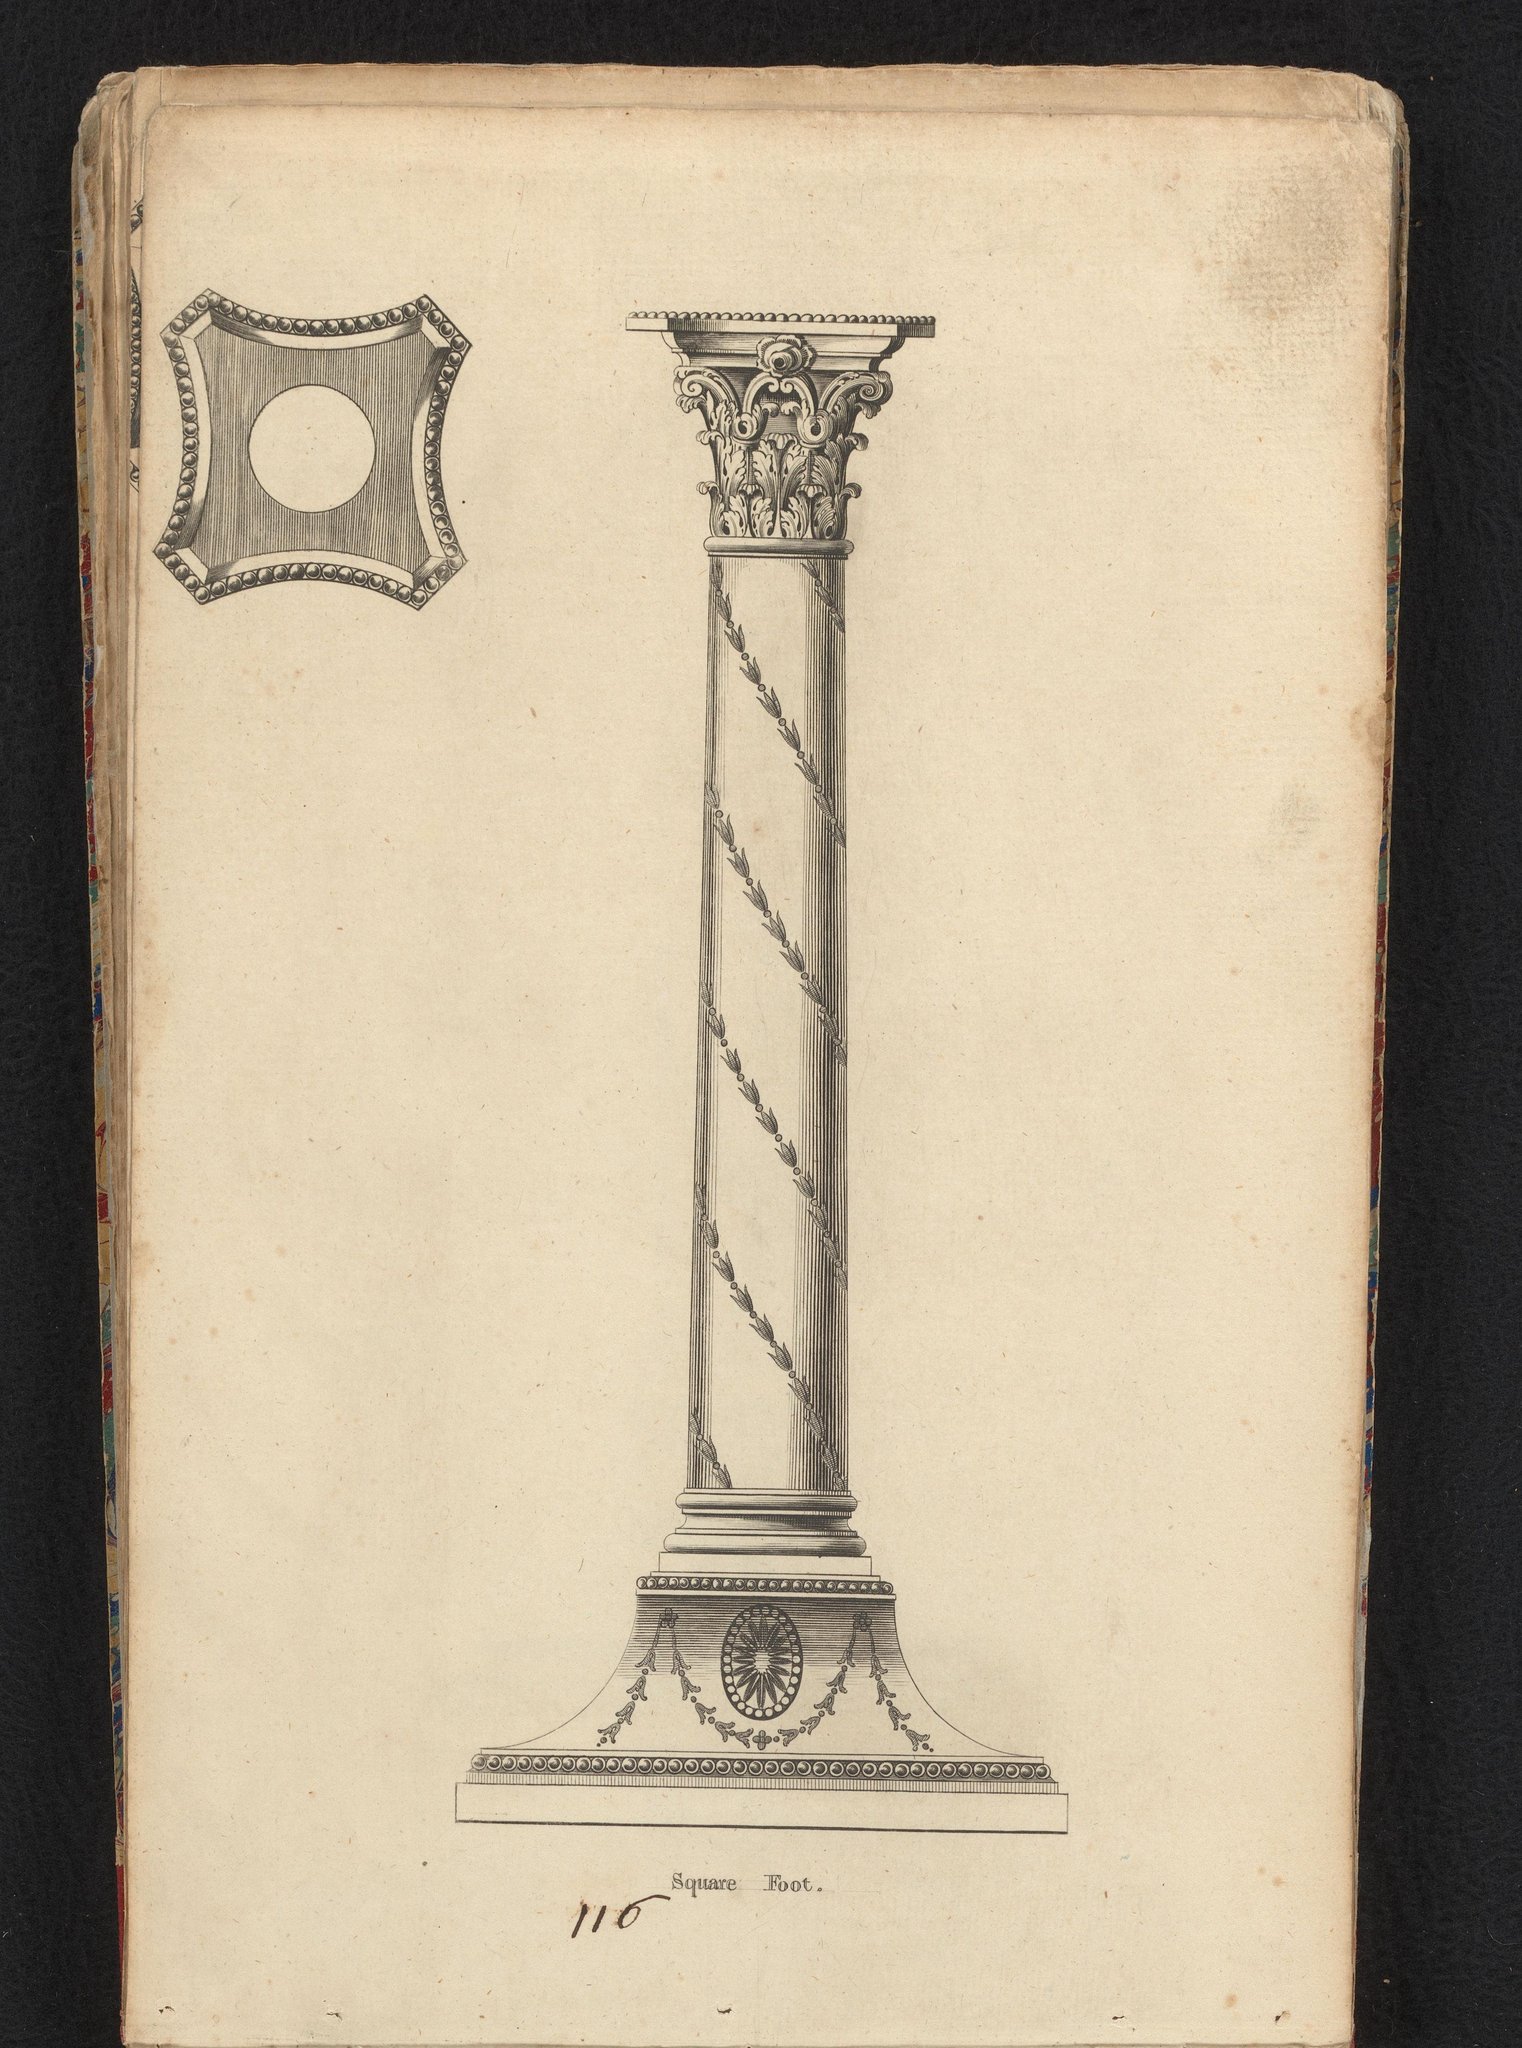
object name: album leaf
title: Ontwerp voor een kandelaar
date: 1784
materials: paper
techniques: engraving, etching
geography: england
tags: candlestick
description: Ontwerp voor een kandelaar met een vierkante voet, op het volle blad. Met detail van de voet. Met gedrukt onderschrift en handgeschreven nr. 116. Onderdeel van een catalogus met assortiment modellen van Sheffield verzilverd vaatwerk (pleet) door Matthew Boulton.